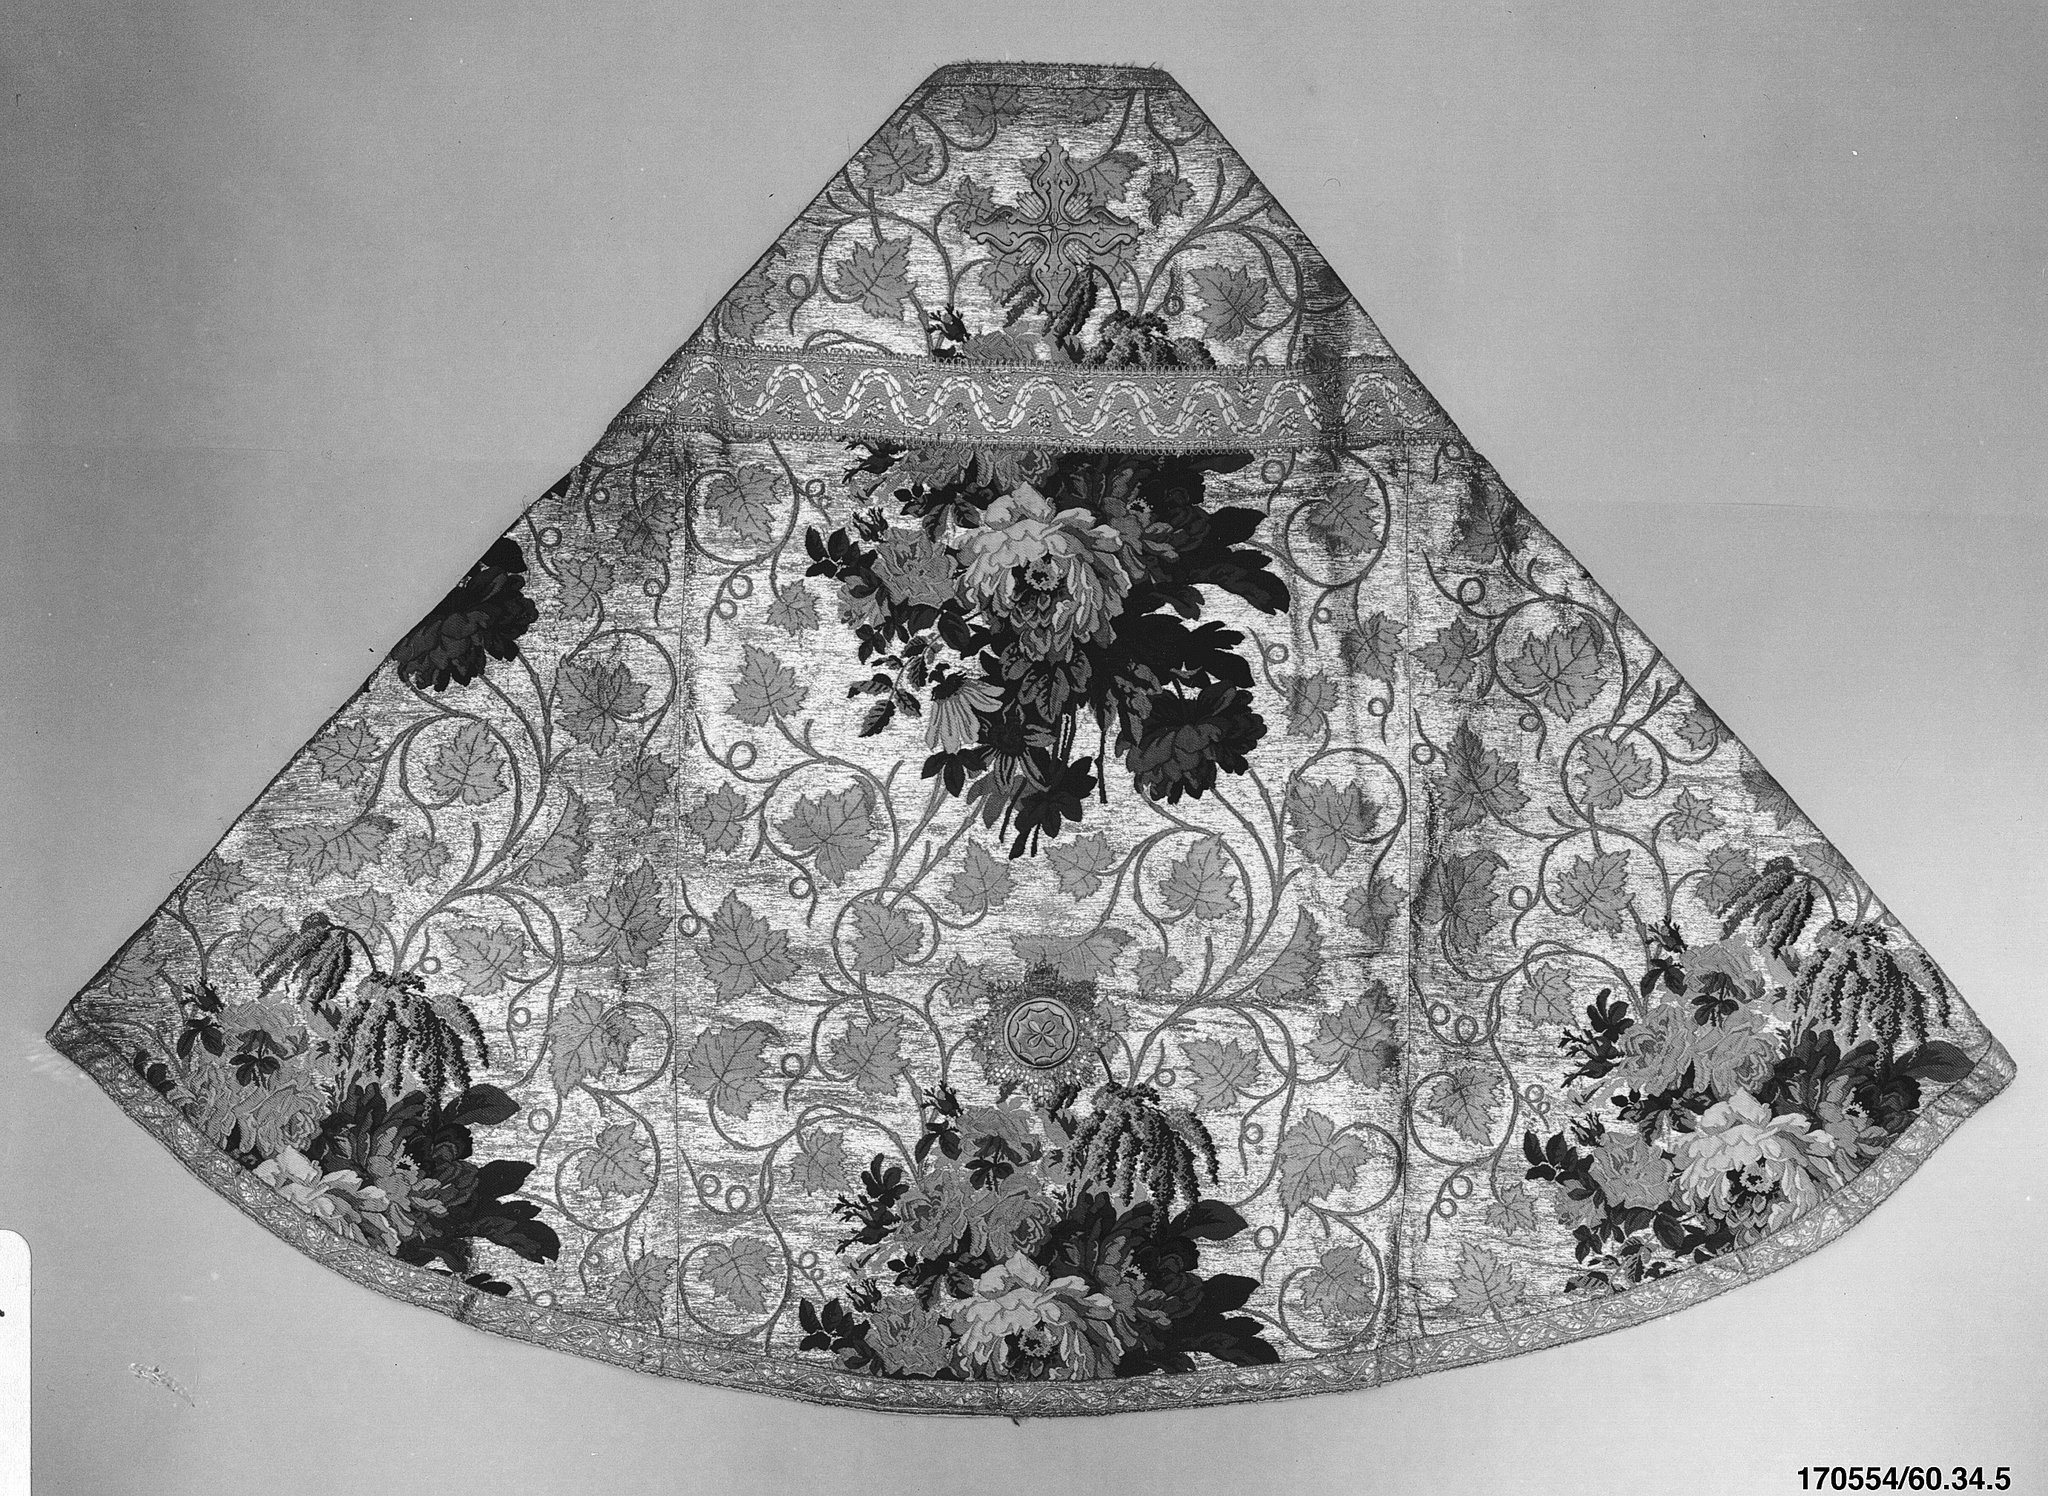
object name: phelonion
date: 1877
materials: metal thread, silk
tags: flowers,leaves